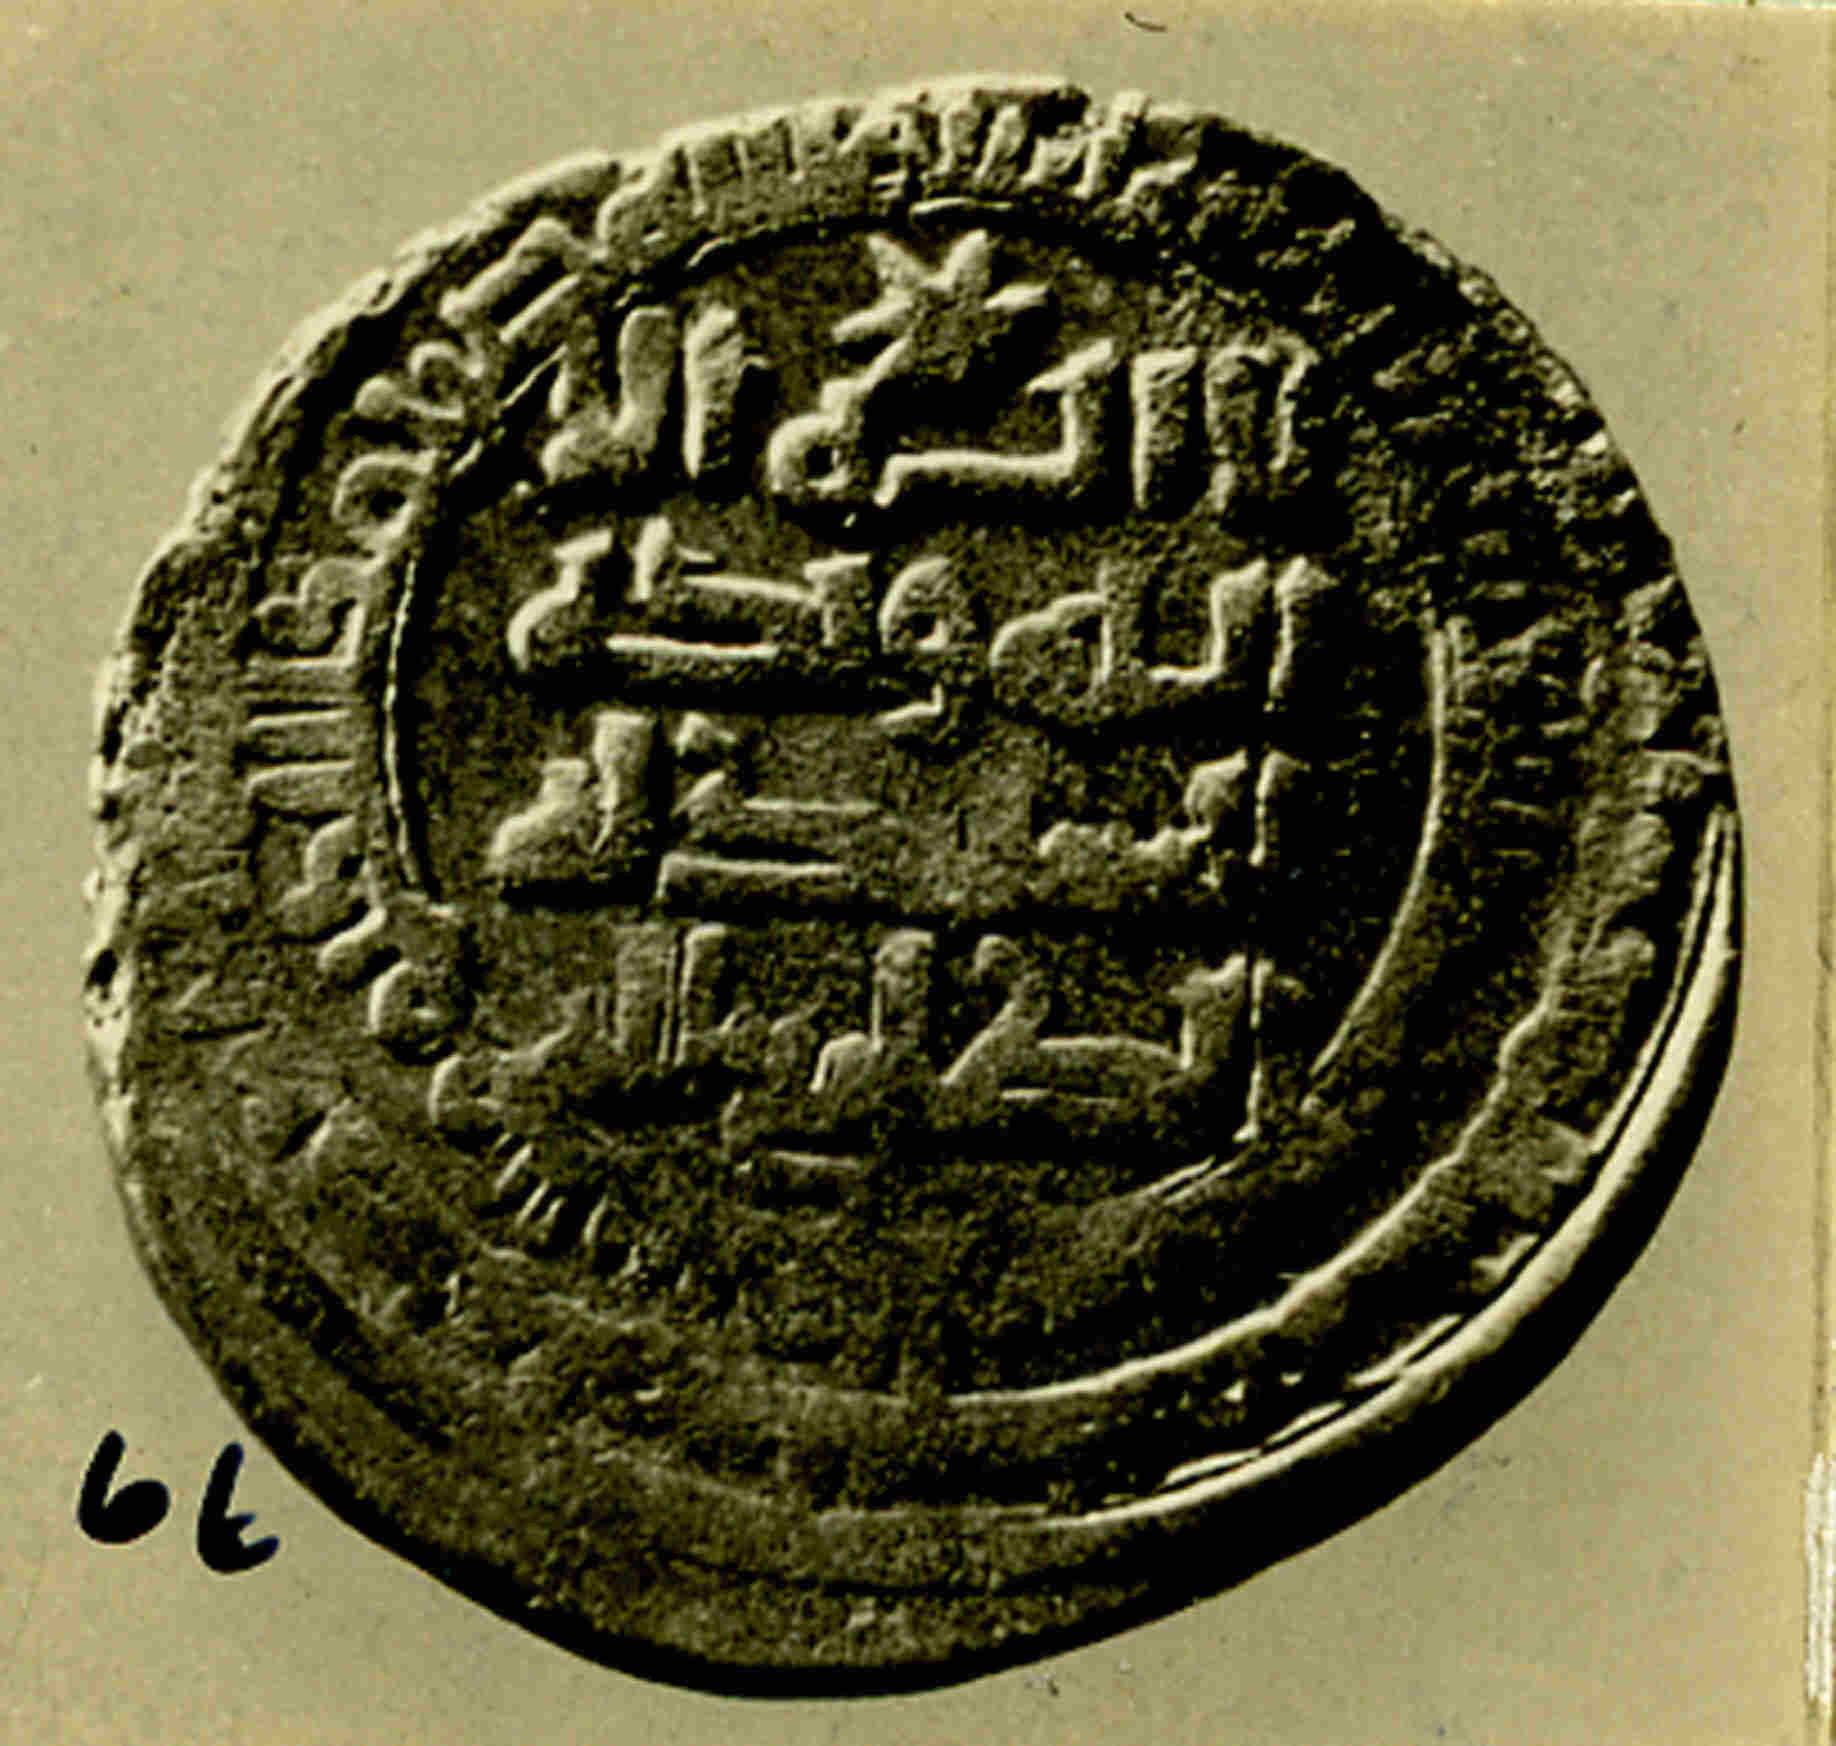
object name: coin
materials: silver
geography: iran